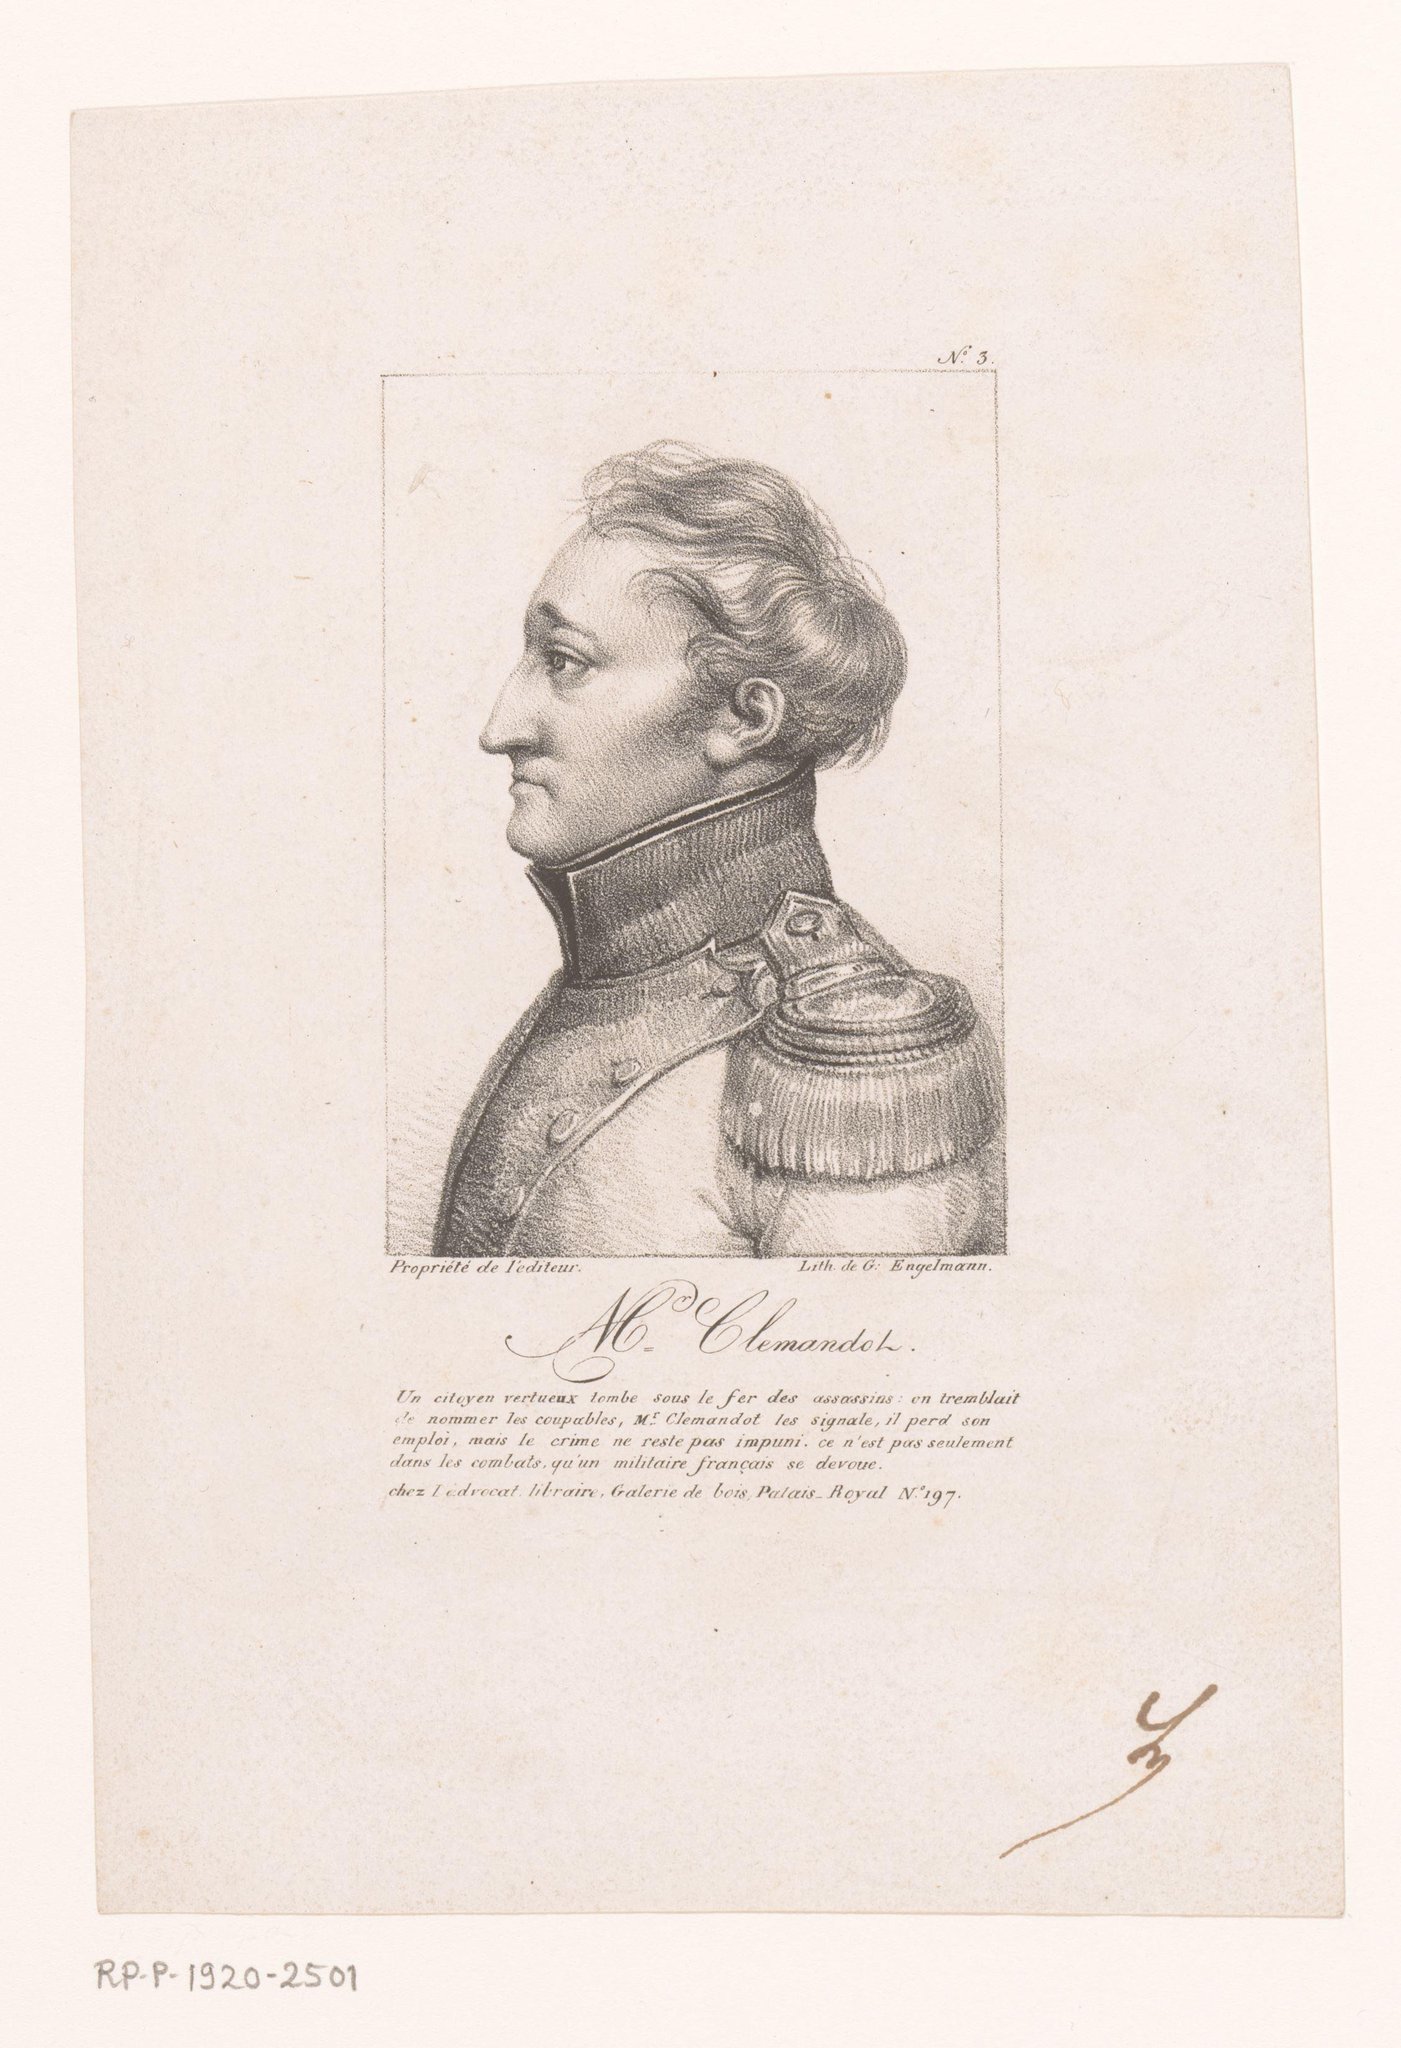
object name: print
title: Betrokkenen bij de rechtszaak over de moord op Fualdès in 1818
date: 1816-1839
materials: paper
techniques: lithograph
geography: paris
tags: historical persons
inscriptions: collector's mark: Lugt 2228a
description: Antoine Bernardin Fualdès werd op 19 maart 1817 vermoord te Rodez. Deze moord leidde in 1818 tot een rechtszaak die de geschiedenis in zou gaan als een van de beroemdste justitiële affaires van de negentiende eeuw (de 'Affaire Fualdès').